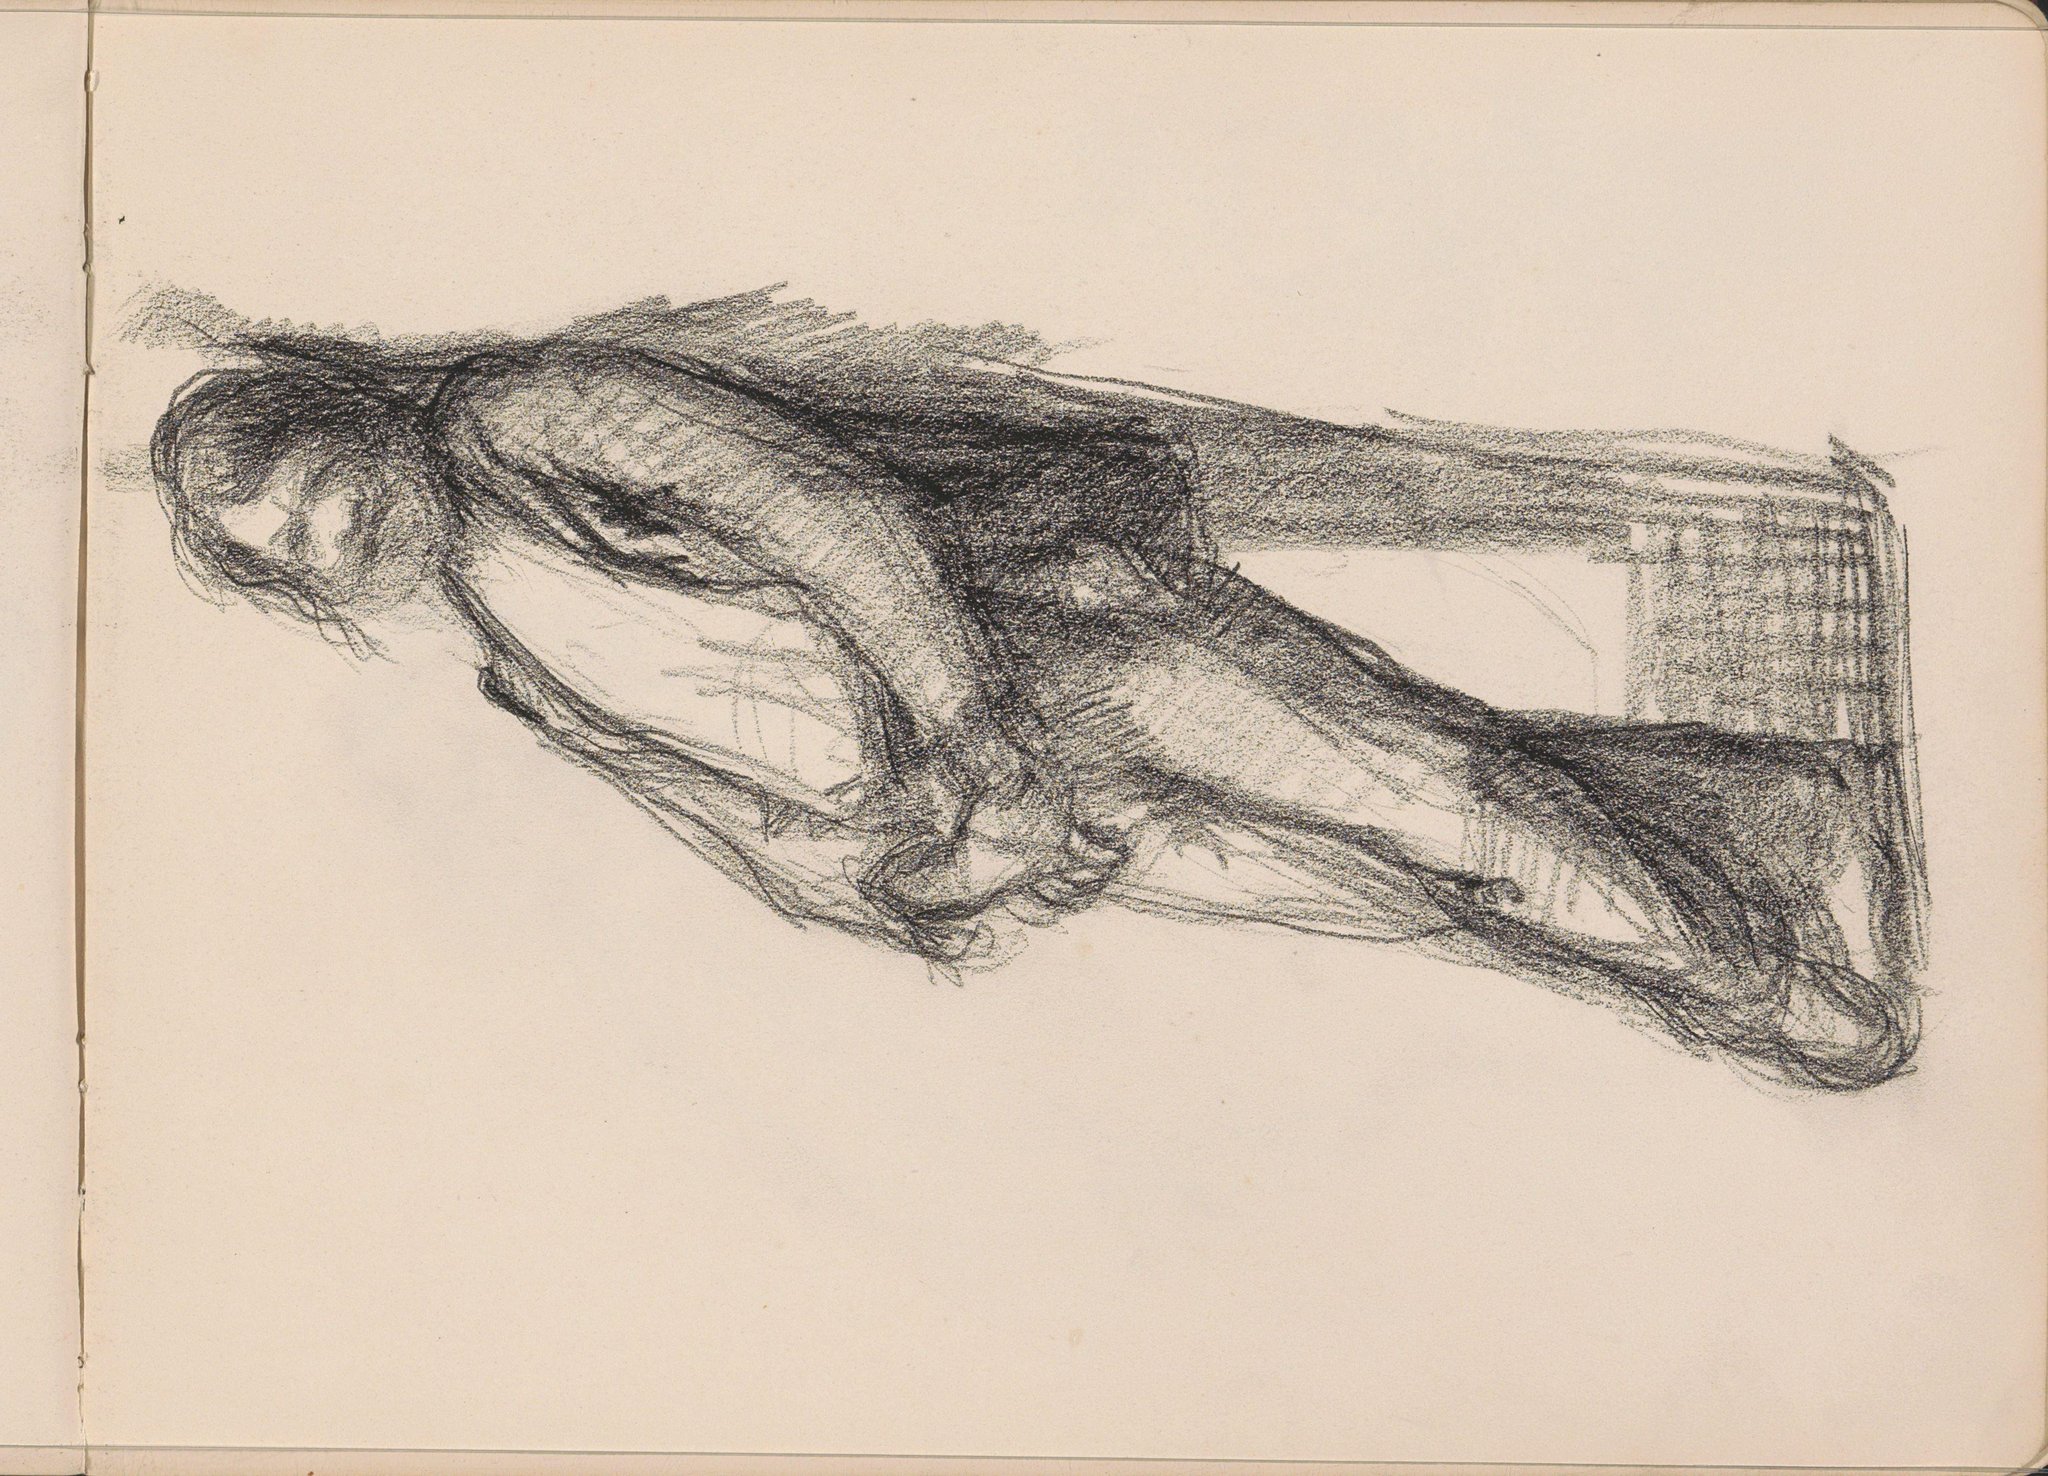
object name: sketchbook leaf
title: Man leunend tegen een muur, de benen gekruist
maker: a.a.l. de grammont-hubrecht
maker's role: draughtsman, painter, print maker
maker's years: 1855-1913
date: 1865-1913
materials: chalk, paper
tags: adult man, standing, leaning, sitting or lying with legs crossed, leaning figure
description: Blad 21 recto uit een schetsboek met 39 bladen.